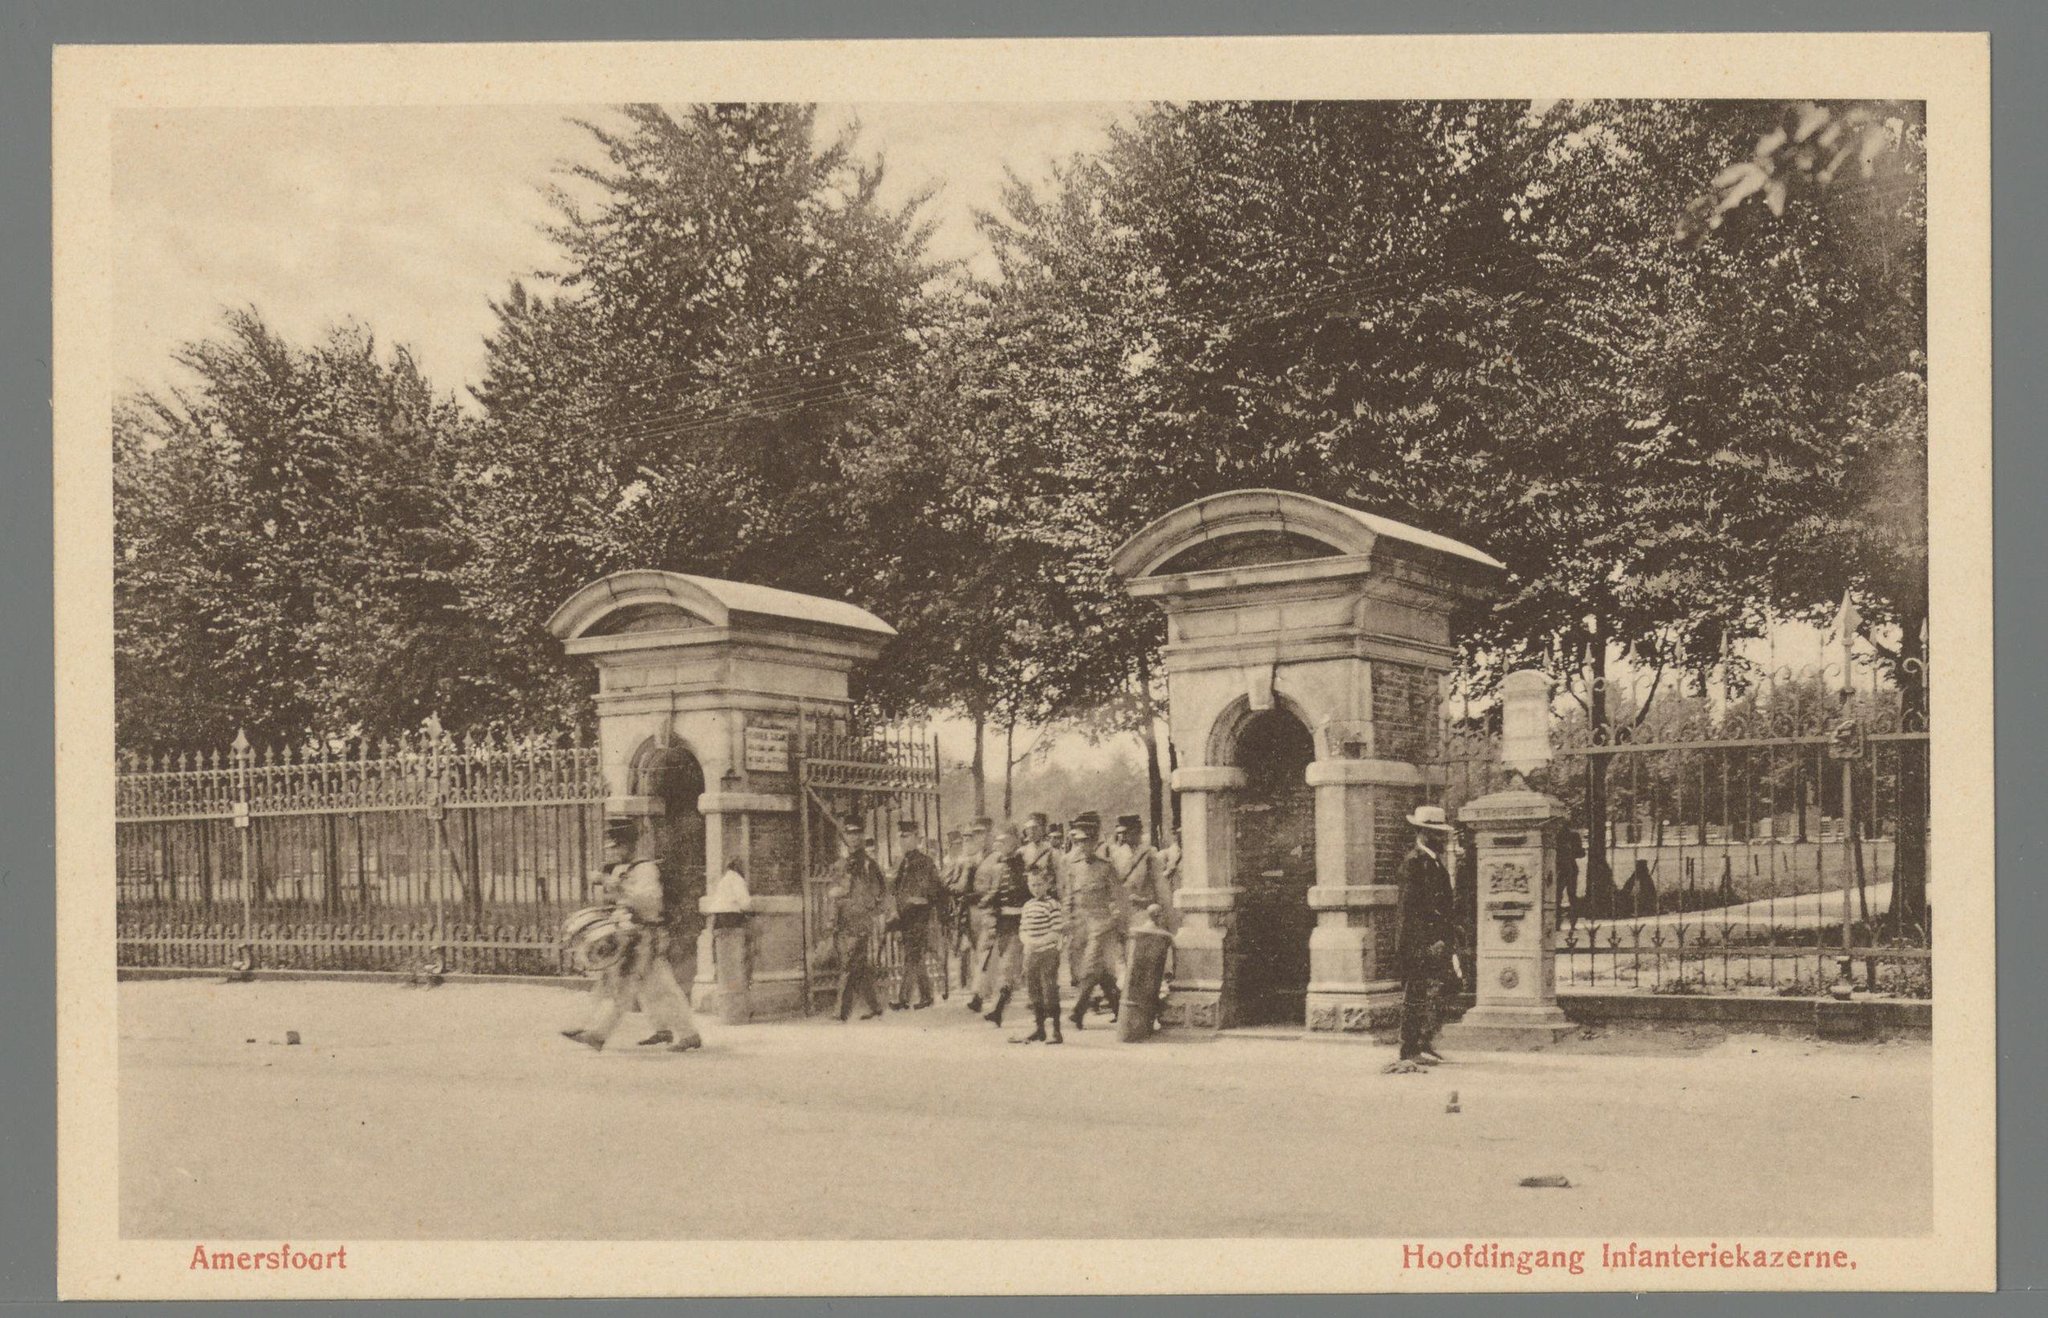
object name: ansichtkaart, prentbriefkaart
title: J.H. Schaefer's Platino Edition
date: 1913-1926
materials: cardboard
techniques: photograph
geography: amersfoort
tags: gate, entrance, barracks